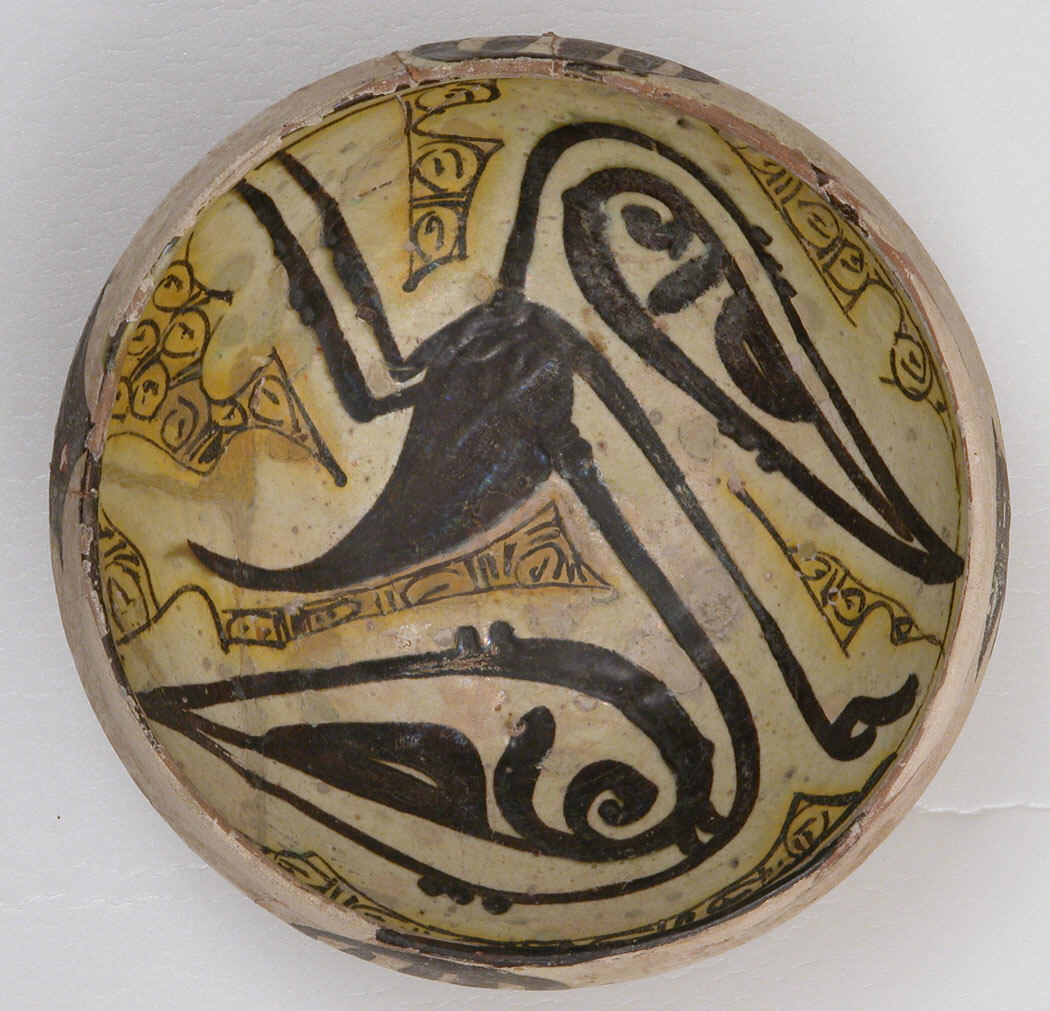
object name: bowl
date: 901-1000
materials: earthenware, glaze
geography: iran